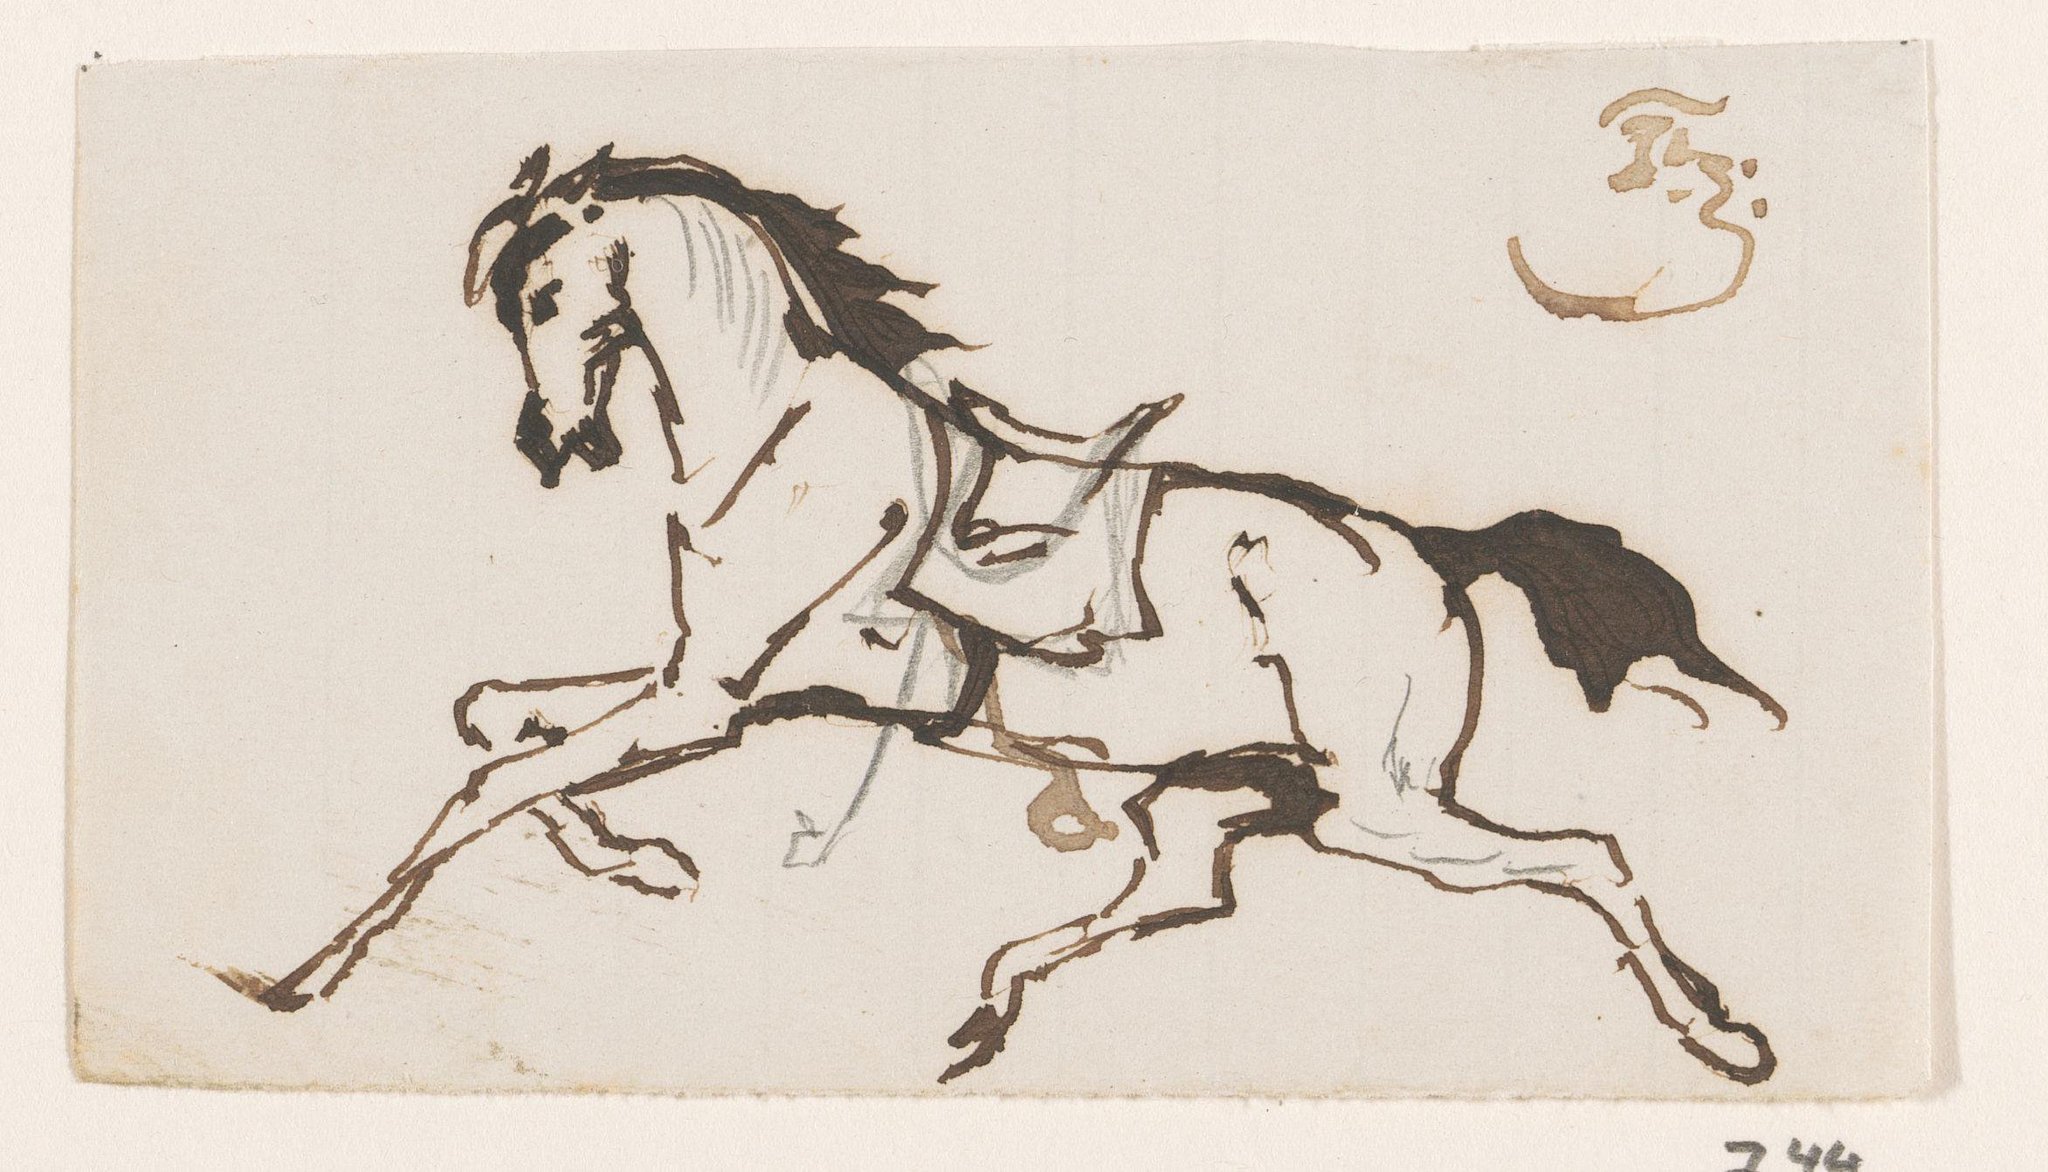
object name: drawing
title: Gezadeld paard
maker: johannes tavenraat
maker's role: draughtsman, painter, print maker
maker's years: 1809-1881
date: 1840-1880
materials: ink, paper, pencil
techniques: pen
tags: horse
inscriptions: signature